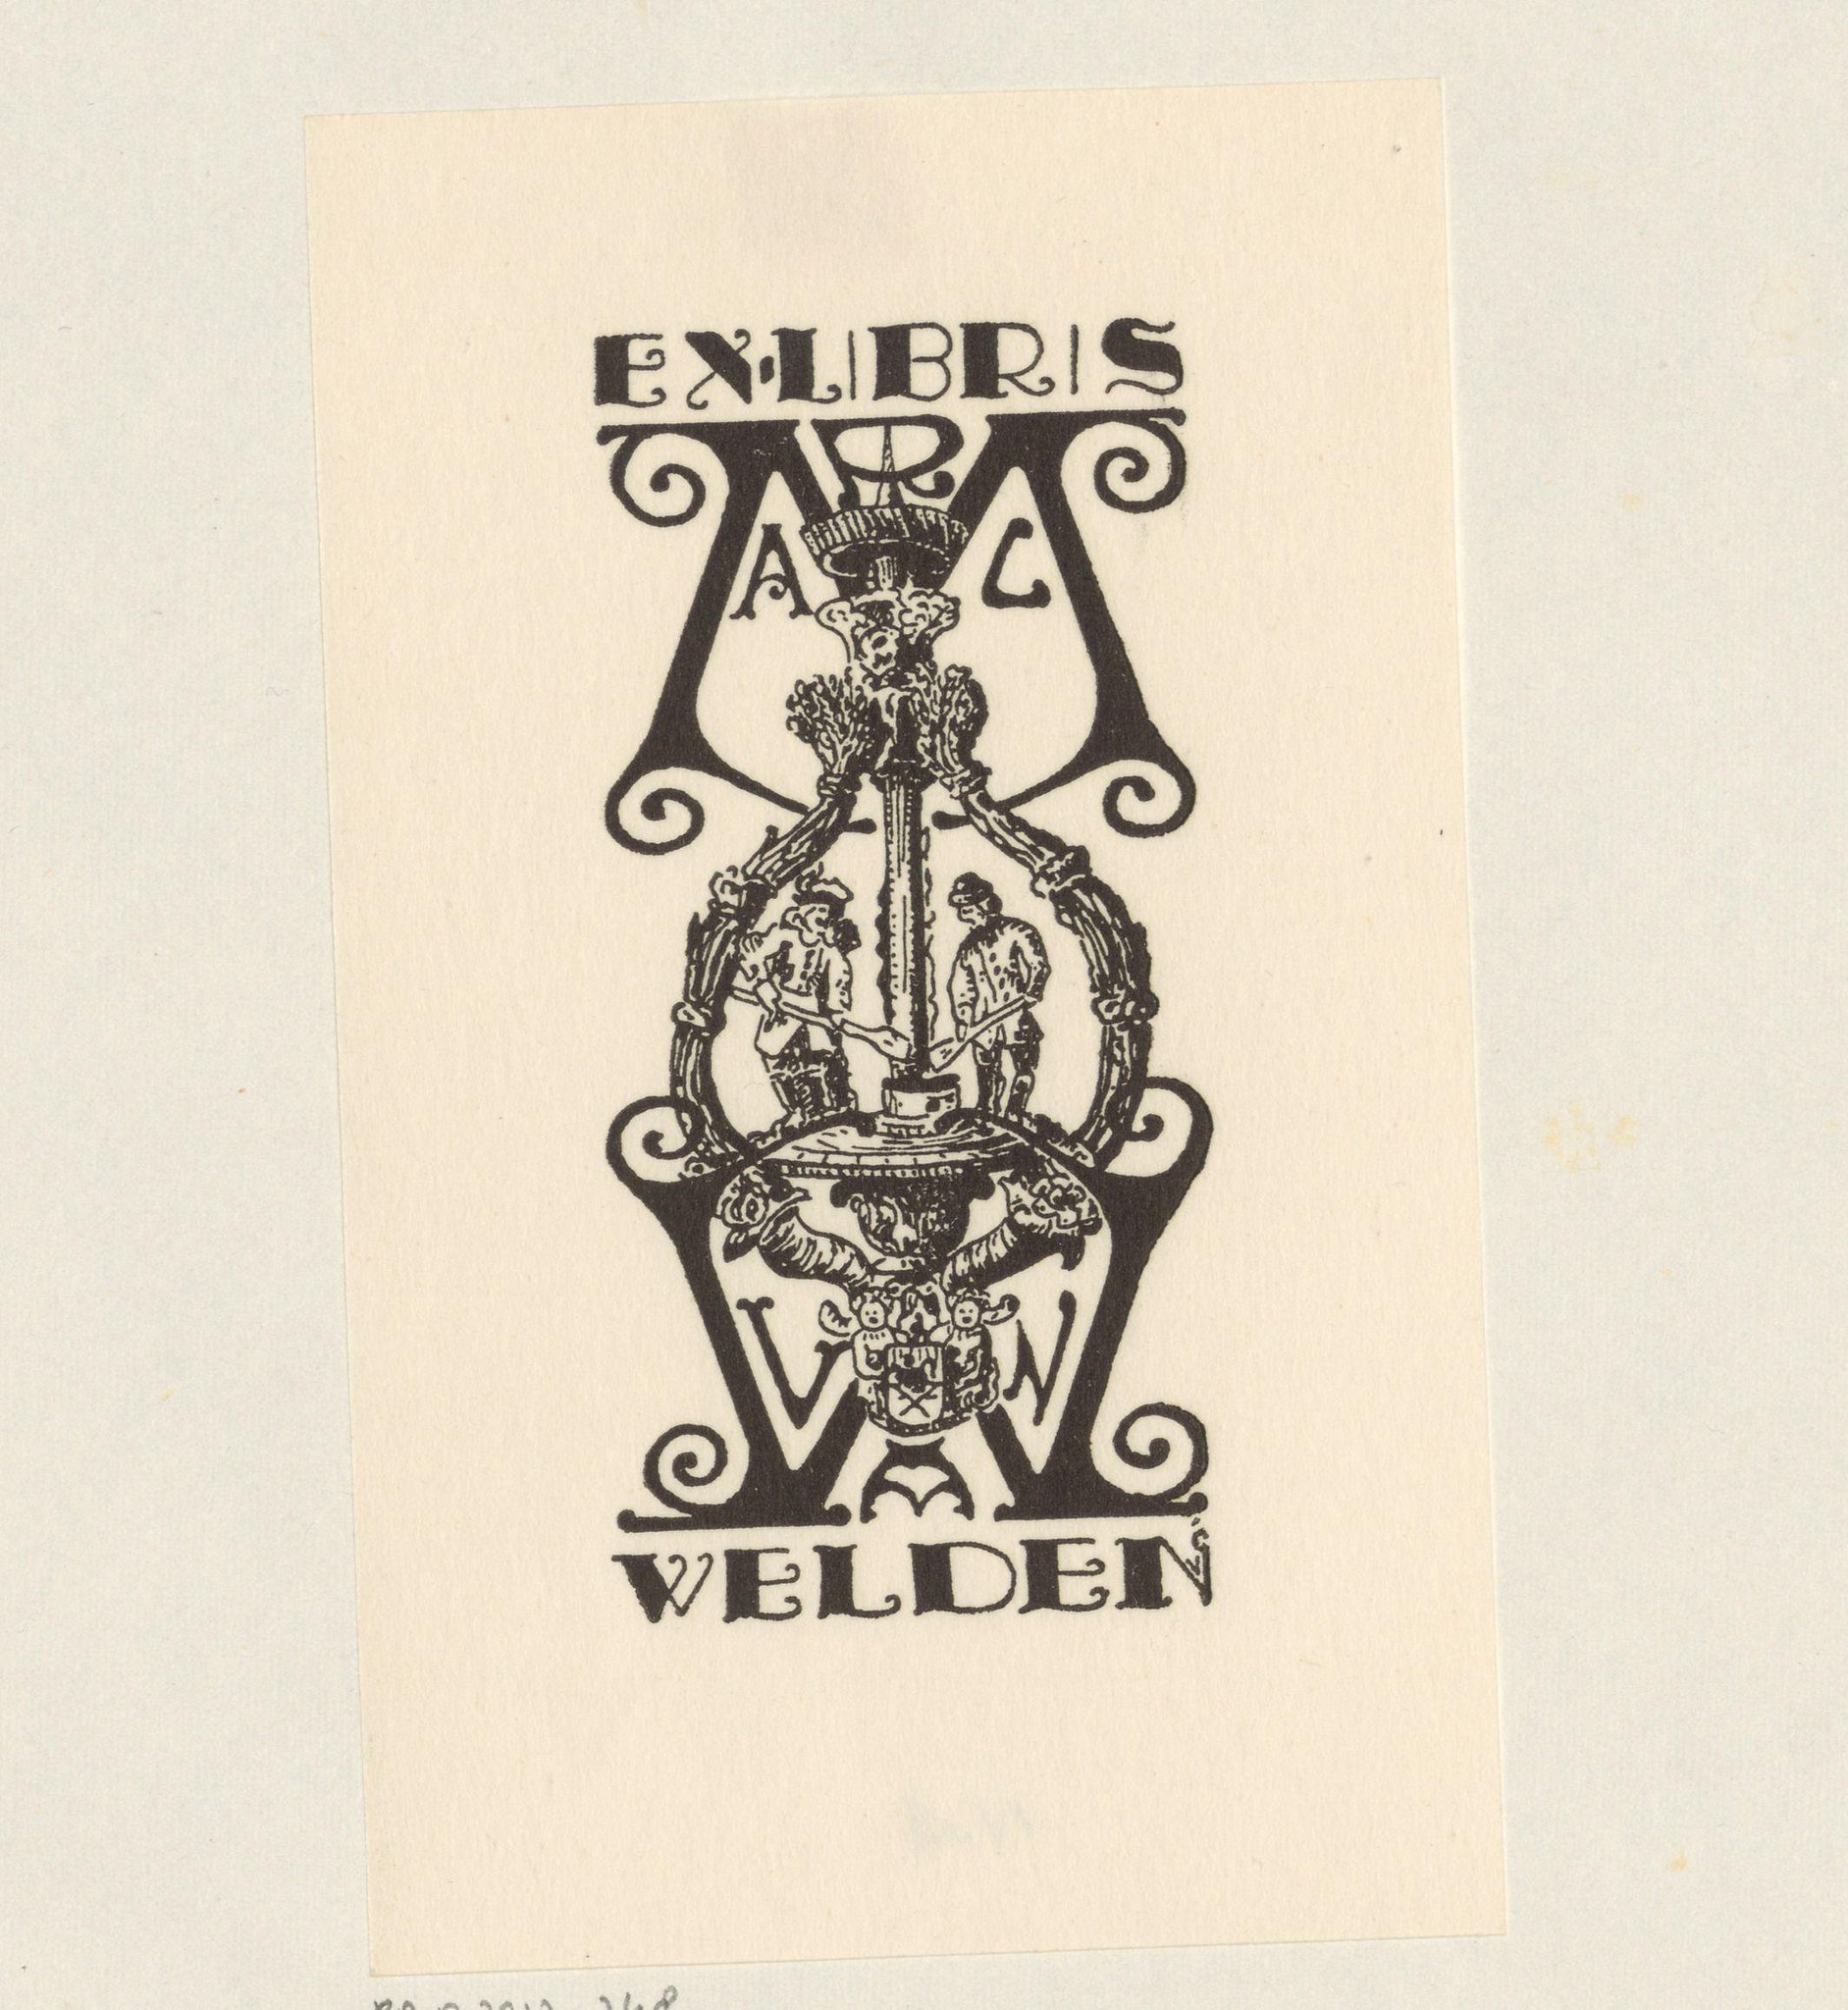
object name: bookplate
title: Ex libris van Welden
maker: Anonymous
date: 1850-1950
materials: paper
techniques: printing block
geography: netherlands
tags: standing figure, spading ~ soil cultivation, armorial bearing, heraldry